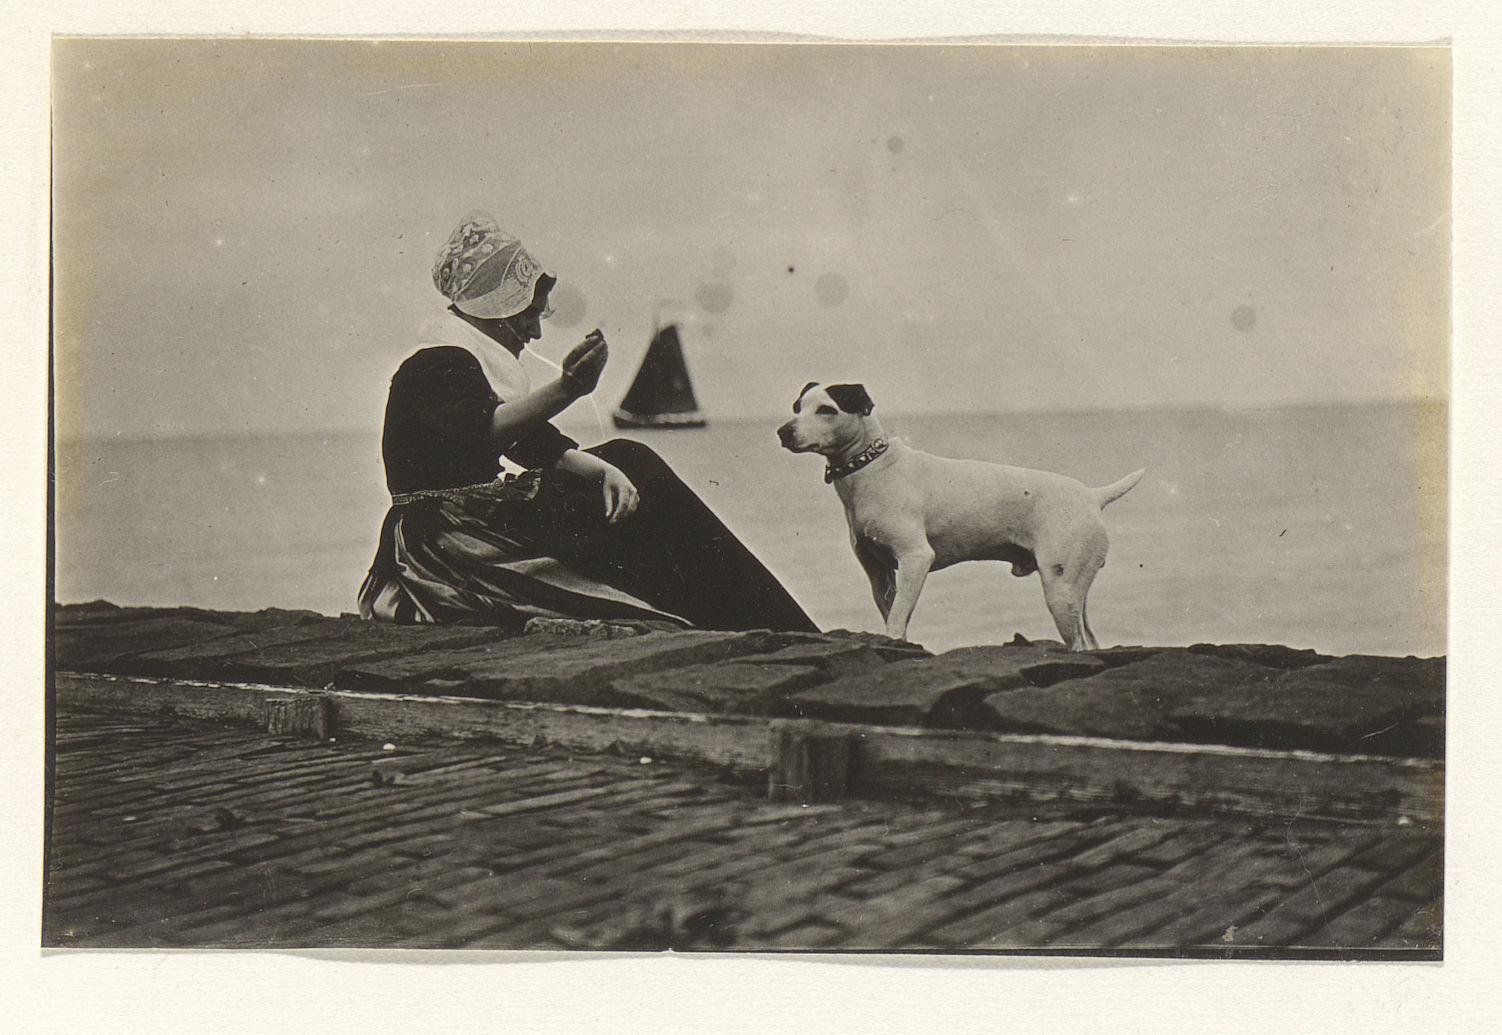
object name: album leaf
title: Vrouw in klederdracht met een hond aan een water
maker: george hidderley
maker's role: fotograaf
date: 1900-1910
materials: paper, photographic support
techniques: gelatin silver print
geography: volendam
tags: adult woman, historical persons, landscapes with waters, waterscapes, seascapes (in the temperate zone), folk costume, regional costume, dog